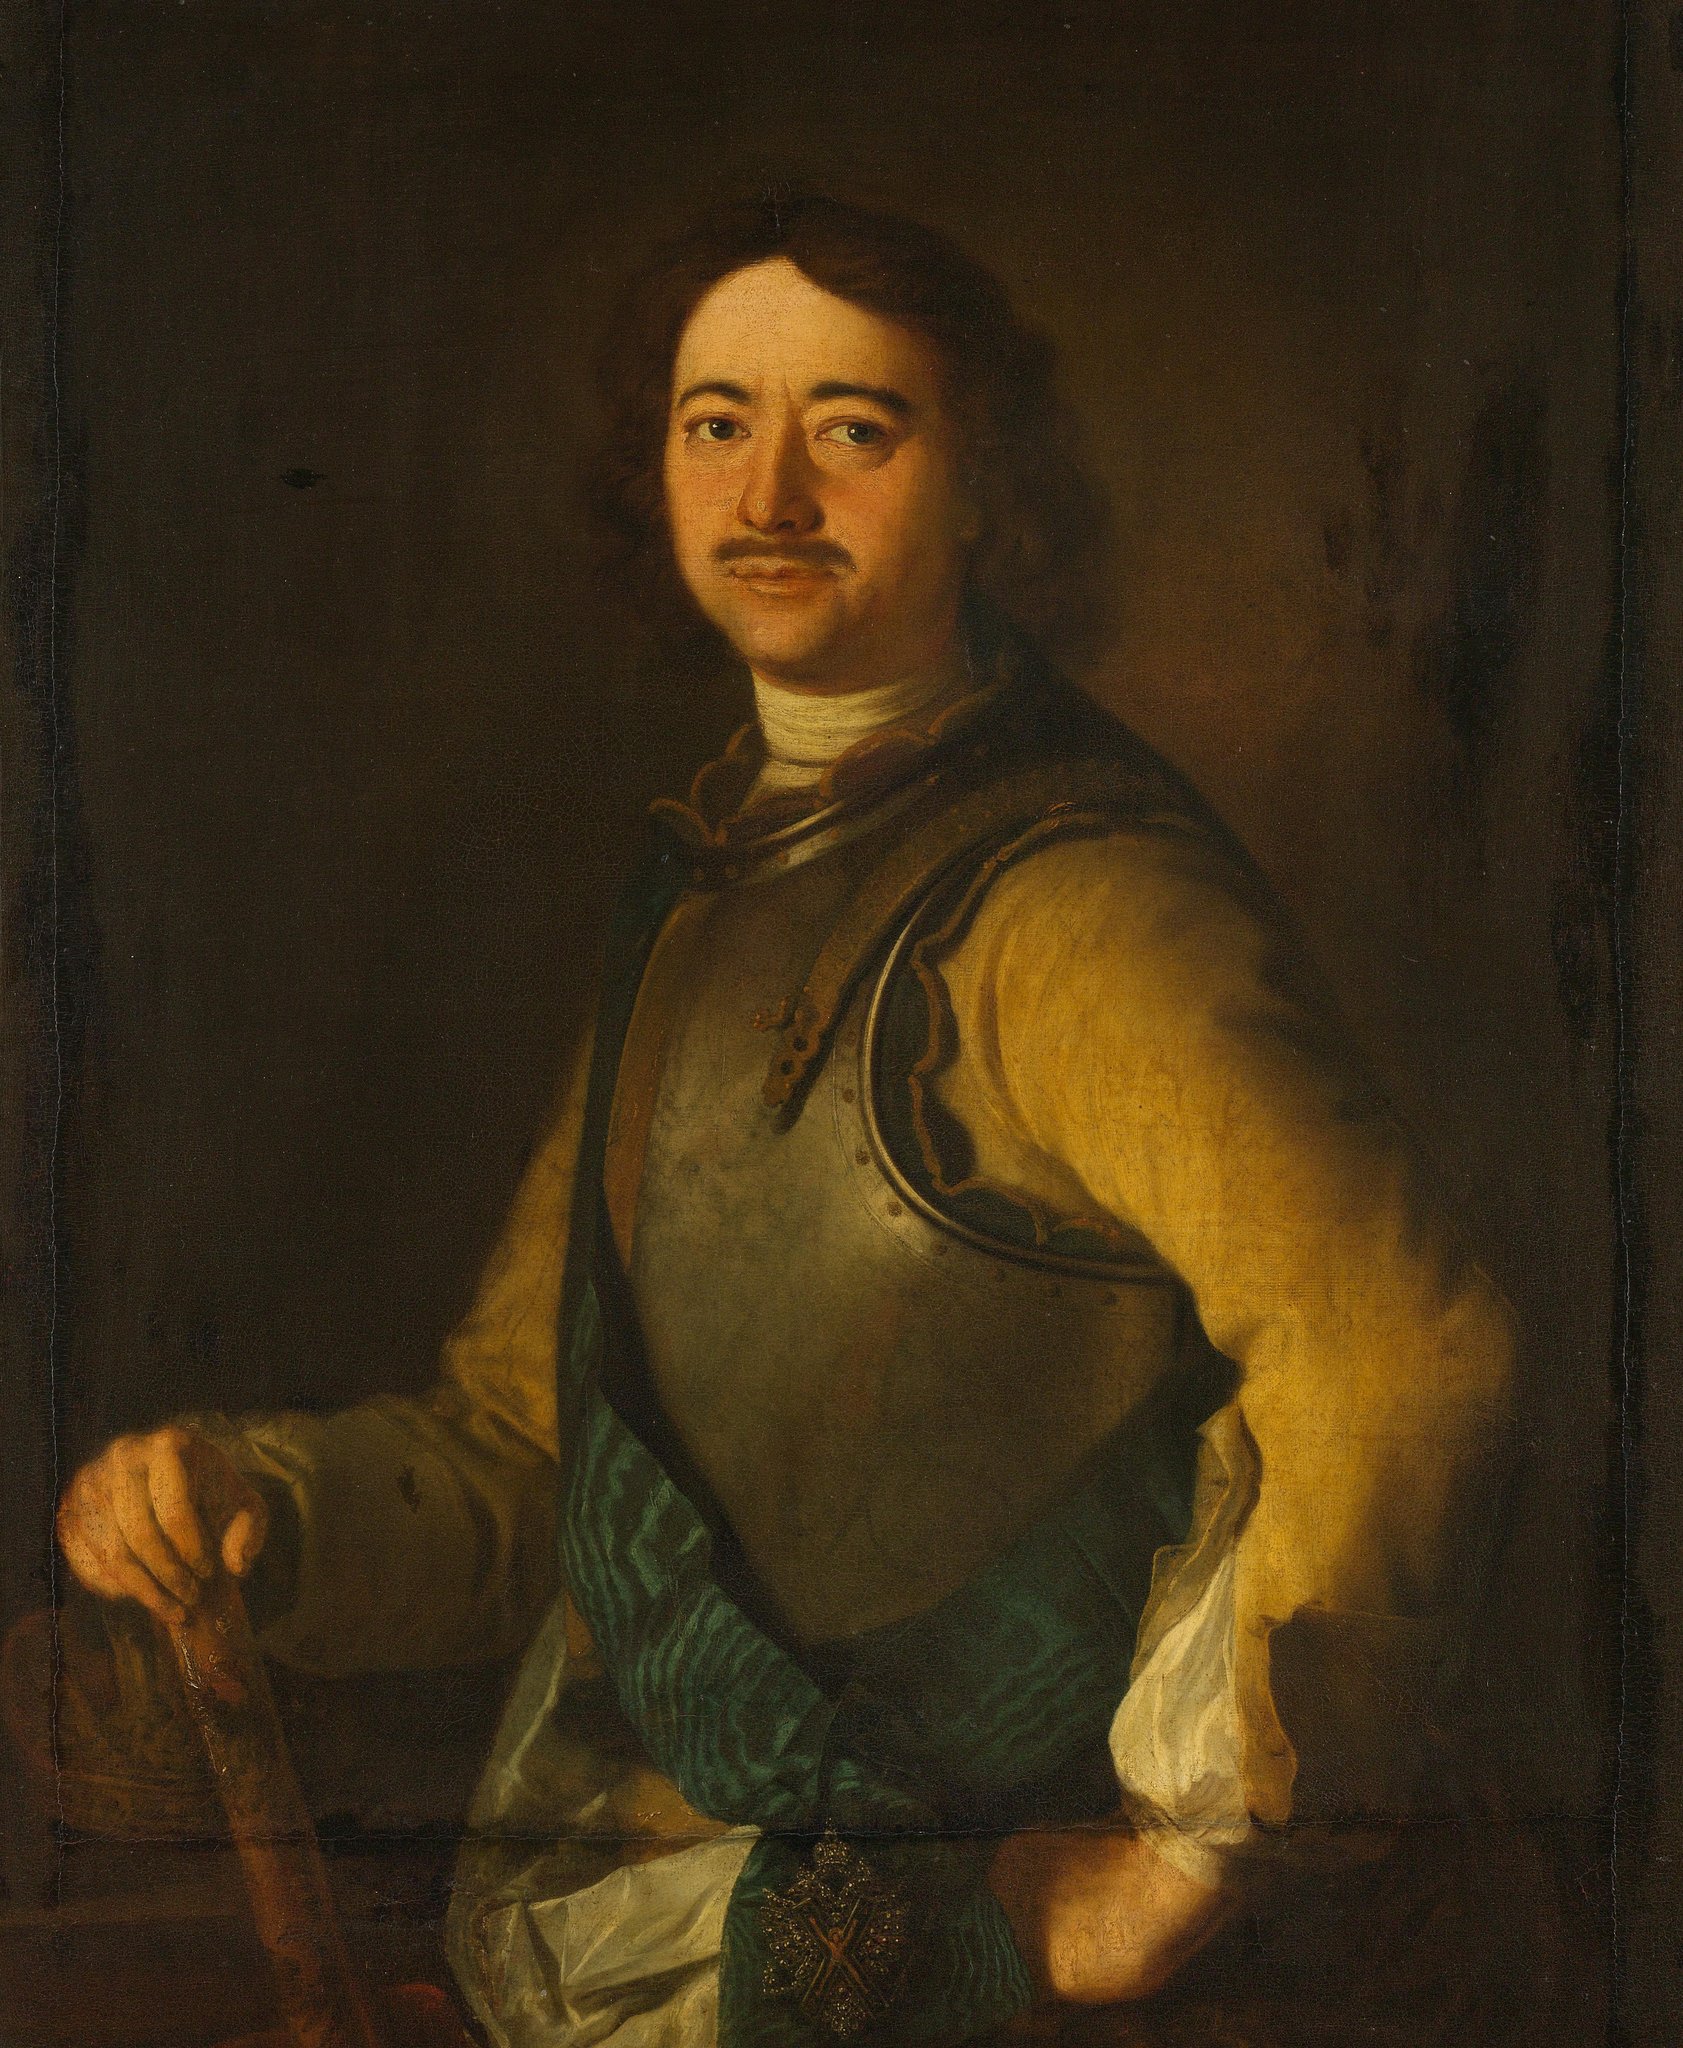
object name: painting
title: Peter the Great, tsar of Russia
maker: Anonymous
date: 1700-1749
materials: canvas, oil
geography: russia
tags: peter i de grote (tsaar van rusland), historical persons, emperor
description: Peter the Great, tsar of Russia. Russian school (?), first half 18th century. Peter I (1672-1725) was tsar (emperor) of Russia from 1682 to 1725. It was a reign marked by a series of reforms. Peter took the countries of Western Europe as his model. In1697, a Russian mission was sent to the West to open diplomatic talks. Russia needed allies in the war against the Ottoman Empire. The ambassadors were also ordered to gather scientific and technical information. One of the places they visited was the Dutch Republic. The tsar travelled with the embassy, although in disguise: it was vital that news did not spread to Russia of the tsar's absence from the country. Here Peter is depicted in simple clothes. He is wearing the cross and ribbon of the Order of St Andrew, his own creation.